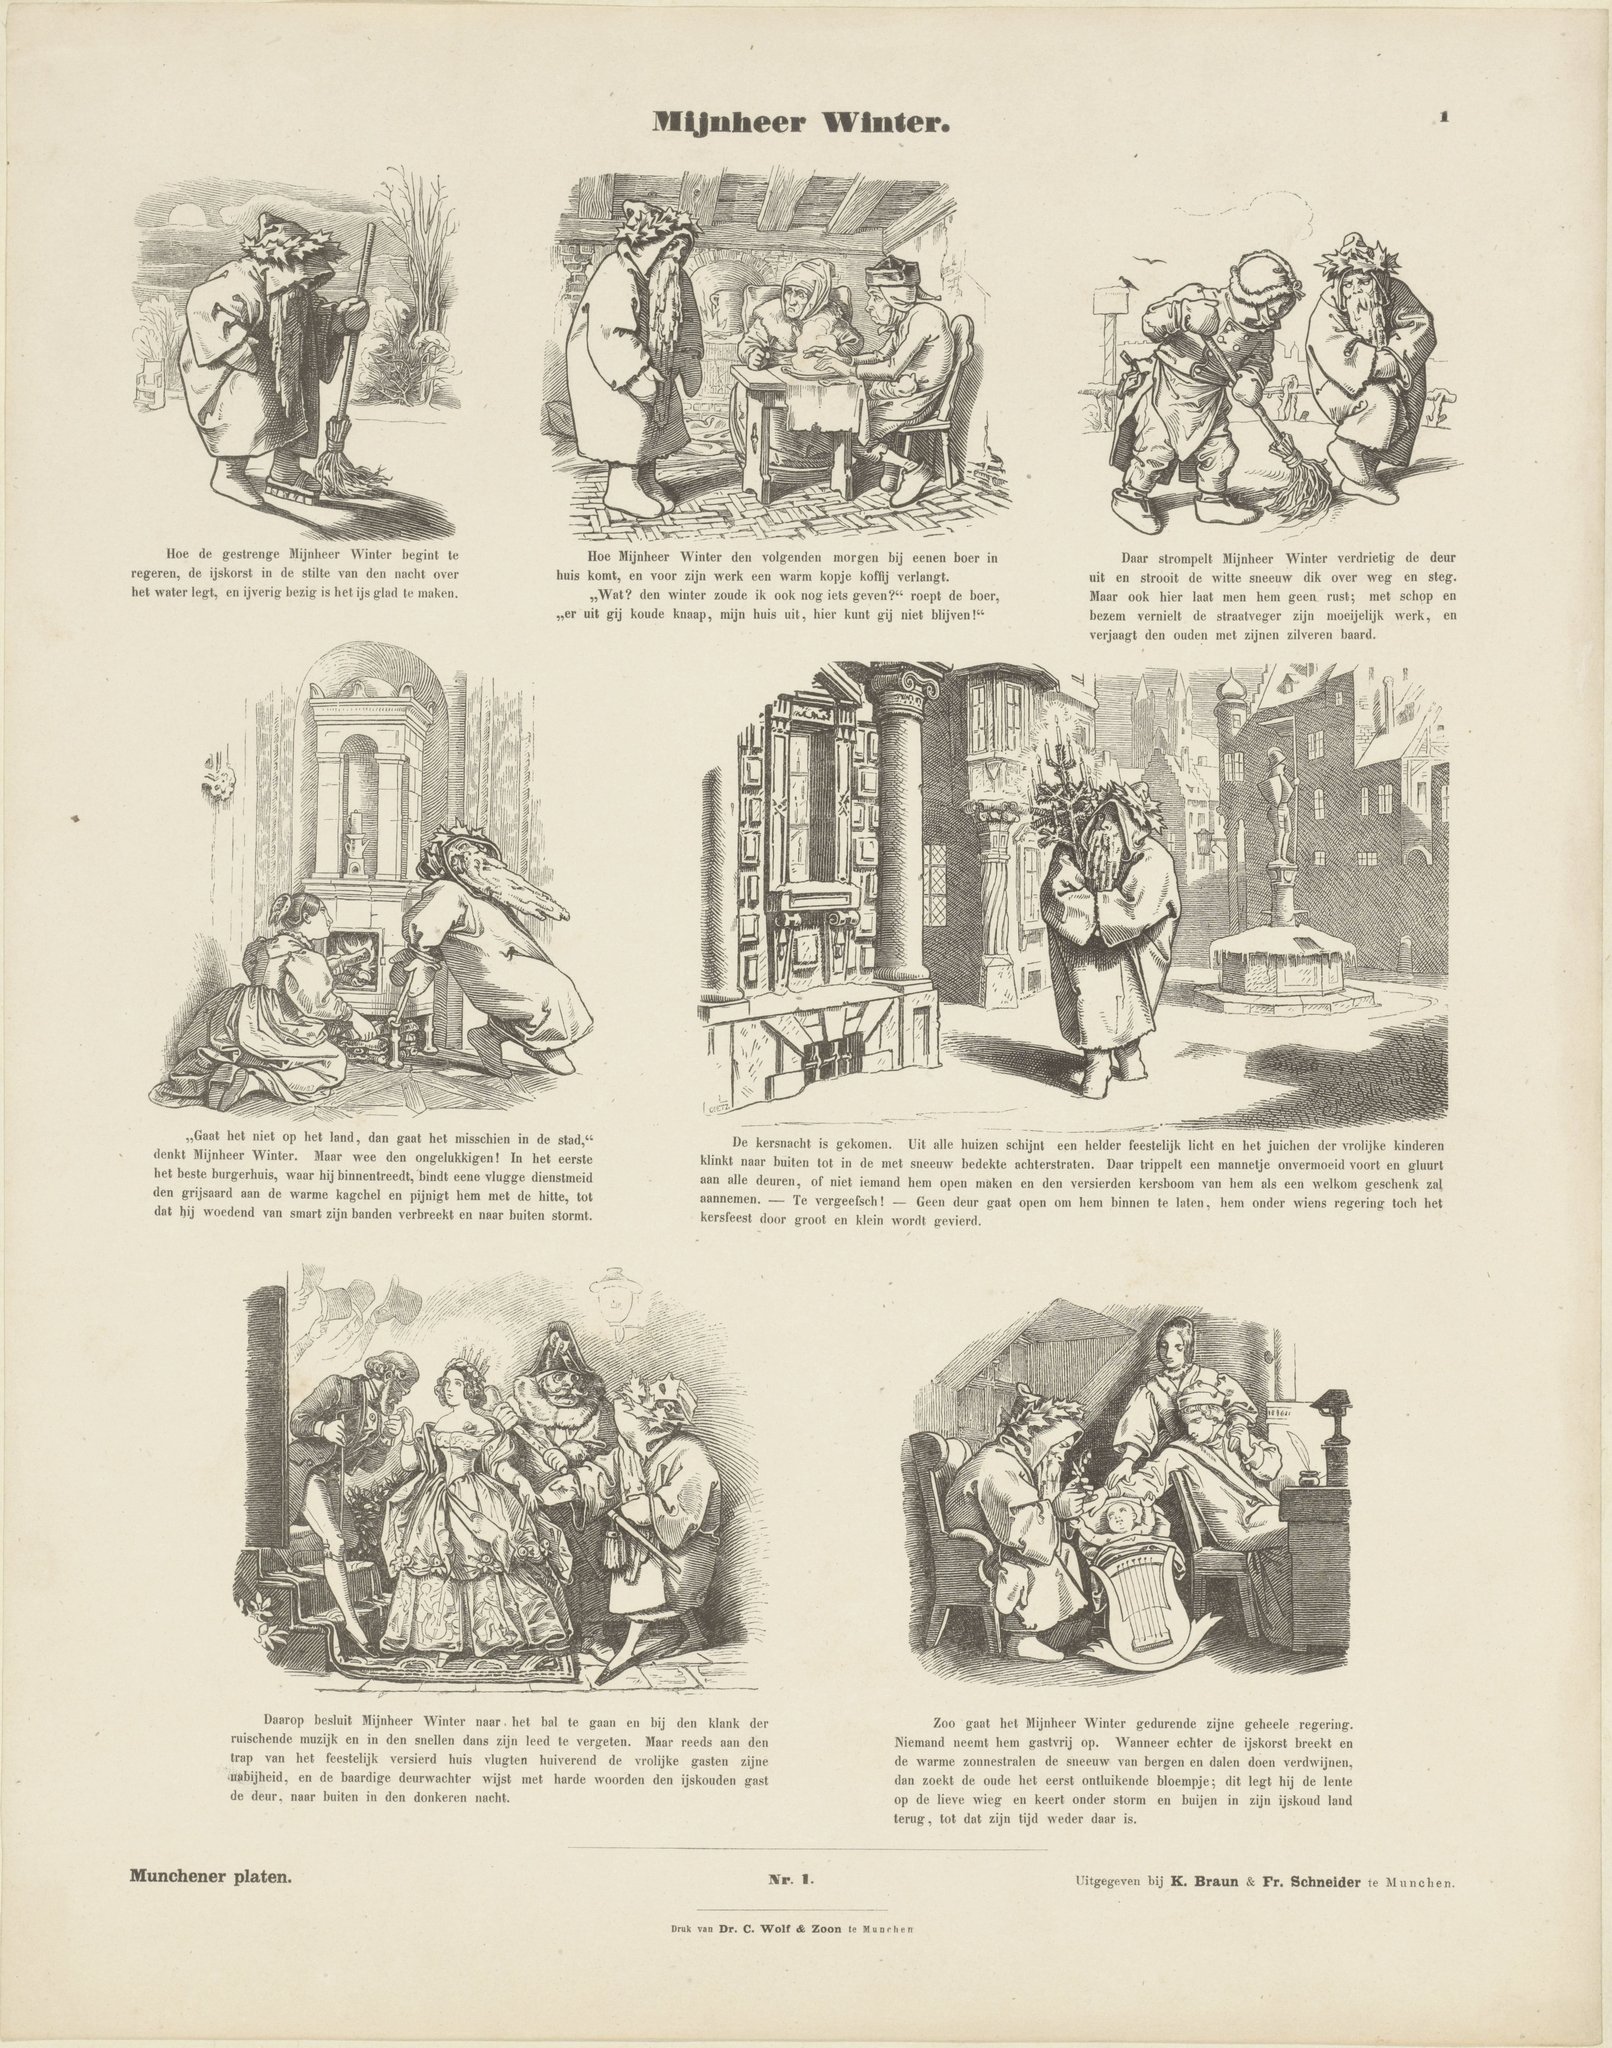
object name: print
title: Mijnheer Winter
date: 1843-1920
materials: paper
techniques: letterpress printing, engraving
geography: munich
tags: winter, 'hyems'; 'inverno' (ripa) (+ ways of representing seasons and months)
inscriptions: collector's mark: Lugt 2760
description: Blad met 7 voorstellingen over hoe meneer Winter (personificatie van de winter) nergens welkom is. Onder elke afbeelding een onderschrift. Genummerd midden onder: Nr. 1.